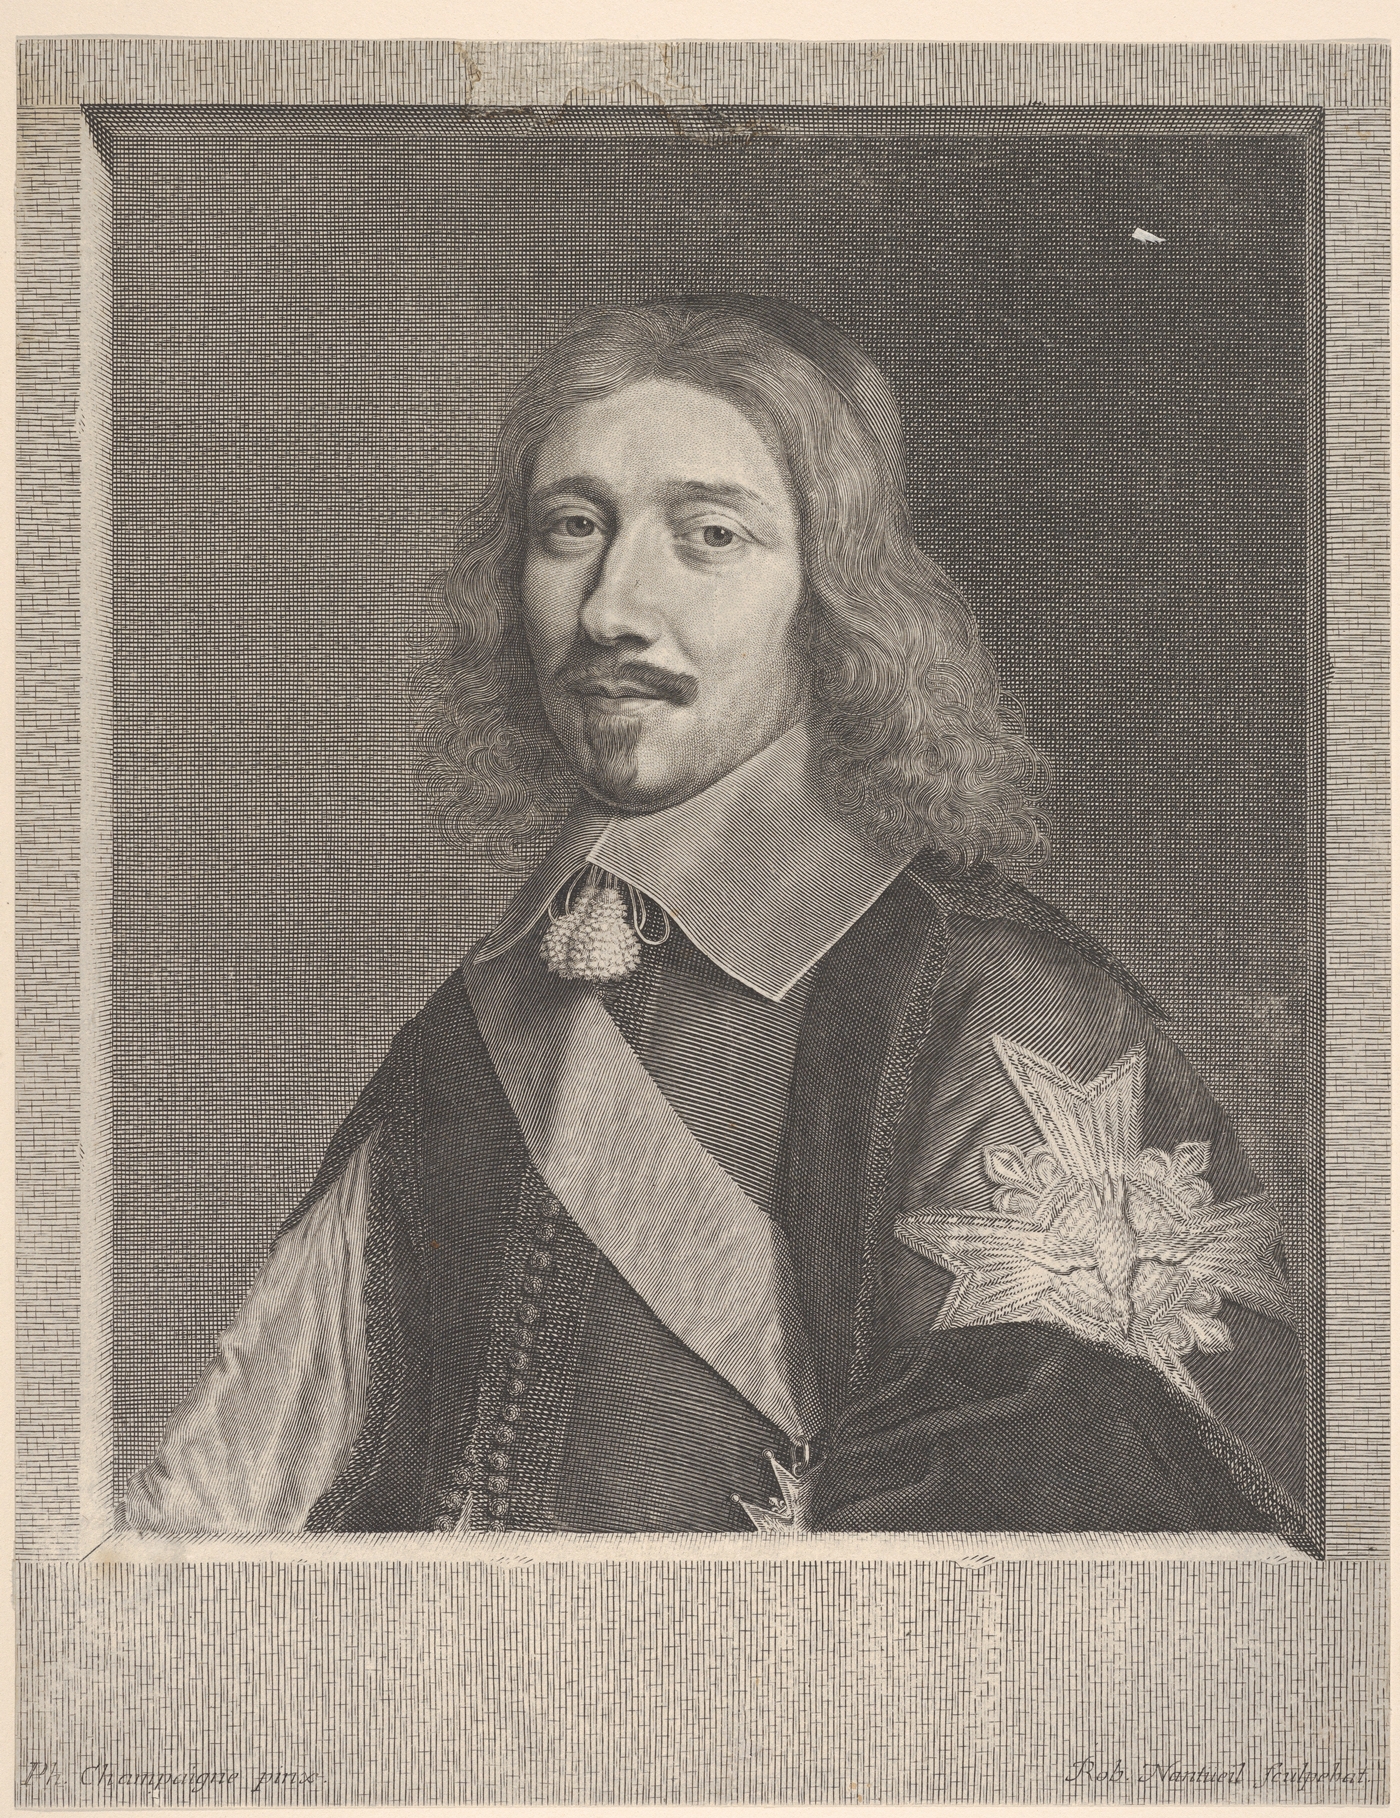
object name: print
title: Michel IV Le Tellier (Le Chancelier)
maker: robert nanteuil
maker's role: artist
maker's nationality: french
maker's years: 1623-1678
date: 1653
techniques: engraving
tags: men,portraits